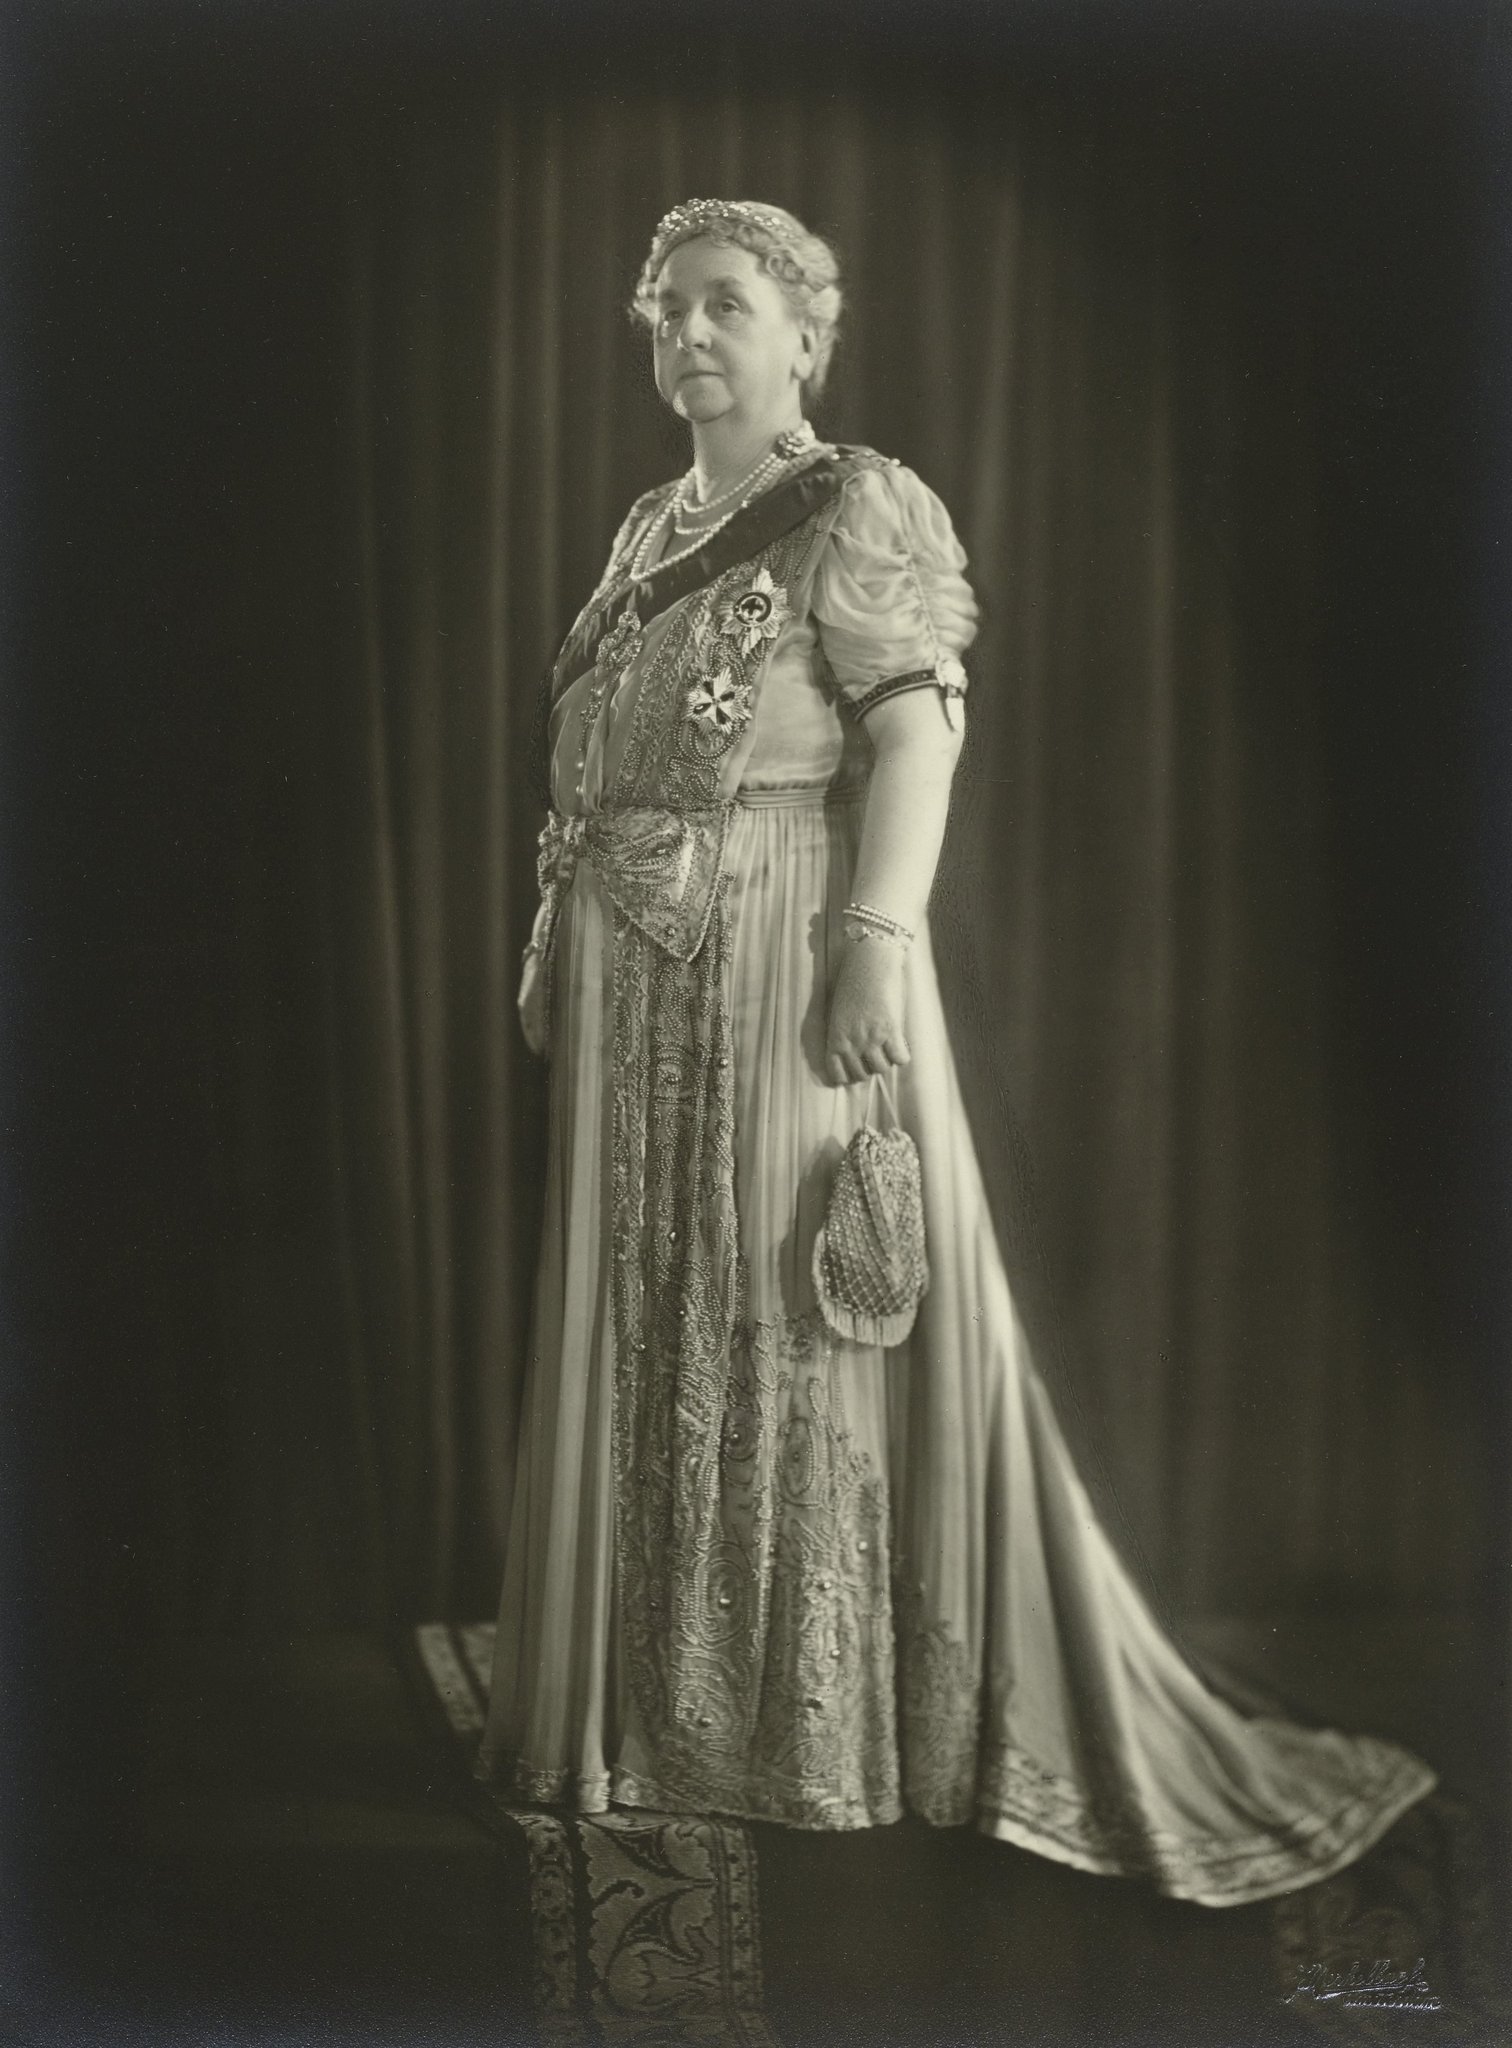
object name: photograph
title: Collectie Merkelbach, portretten van koningin Wilhelmina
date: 1948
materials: photographic support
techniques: photography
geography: amsterdam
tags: the hague, print maker, wilhelmina of the netherlands, amsterdam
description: Koningin Wilhelmina poseert met de Engelse Orde van de Kousenband (boven) en de Militaire Willemsorde (onder); portret ten voeten uit.